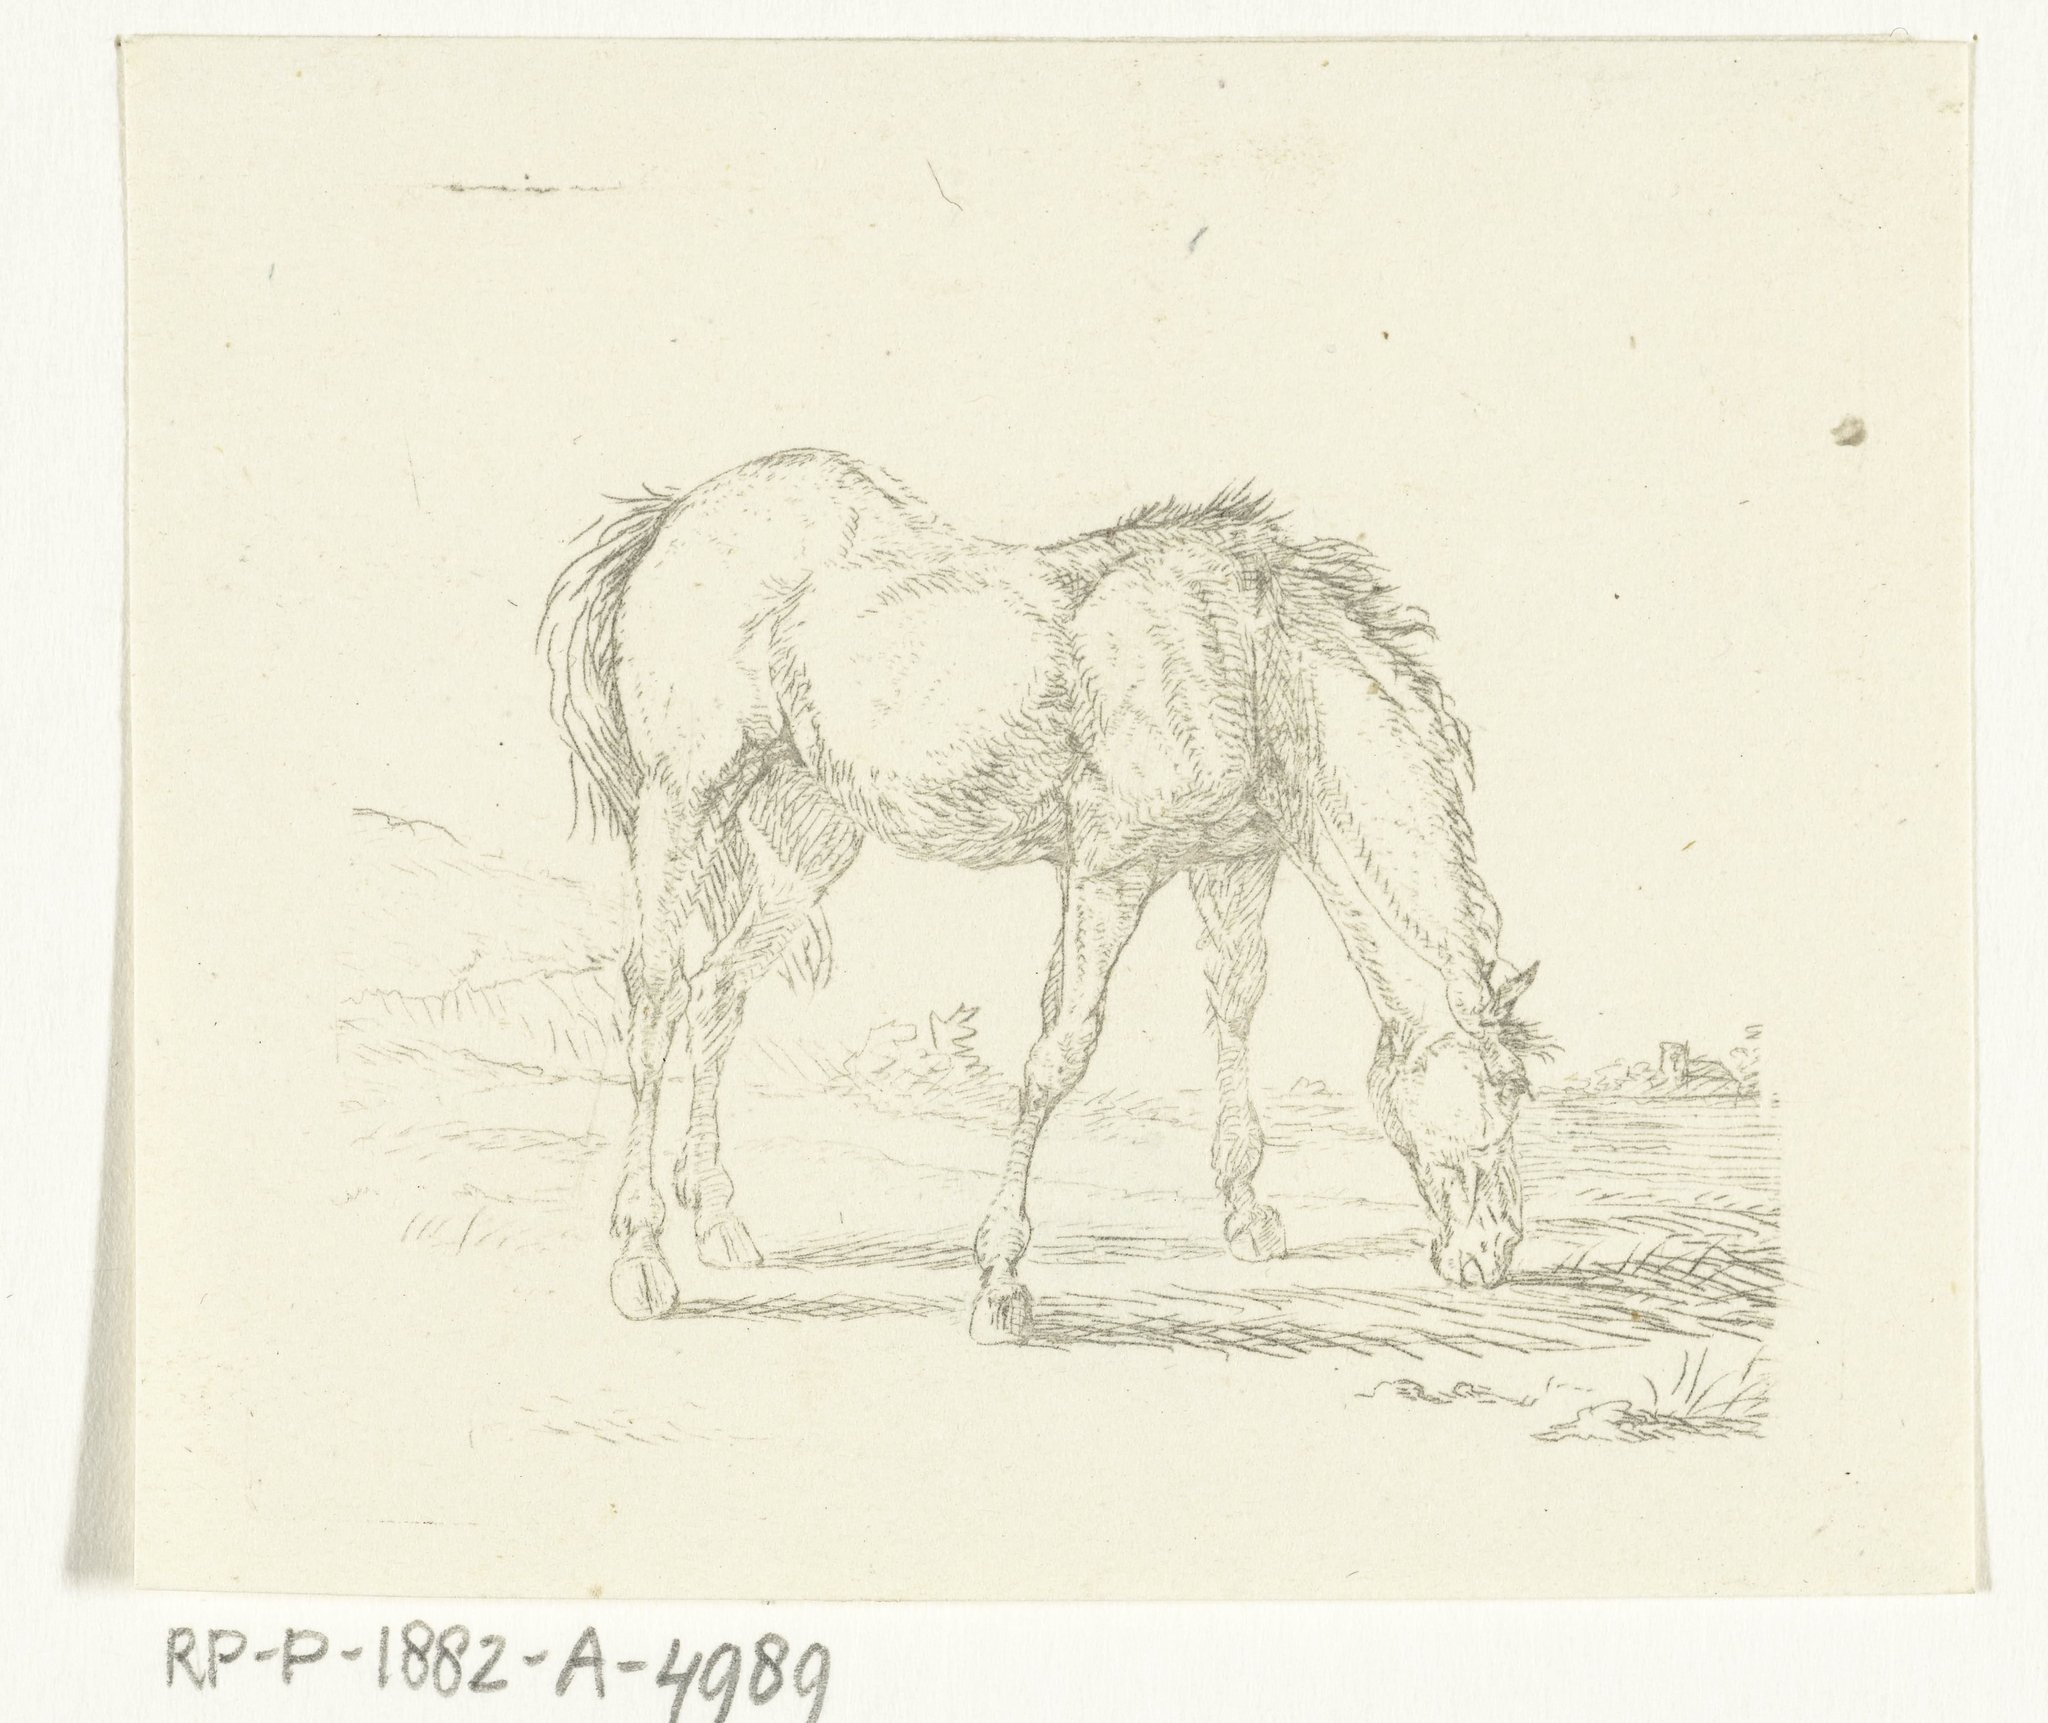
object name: print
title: Grazend paard naar rechts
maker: jan dasveldt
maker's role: draughtsman, print maker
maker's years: 1770-1855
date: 1780-1855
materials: paper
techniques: printmaking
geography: amsterdam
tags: horse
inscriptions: collector's mark: Lugt 2228